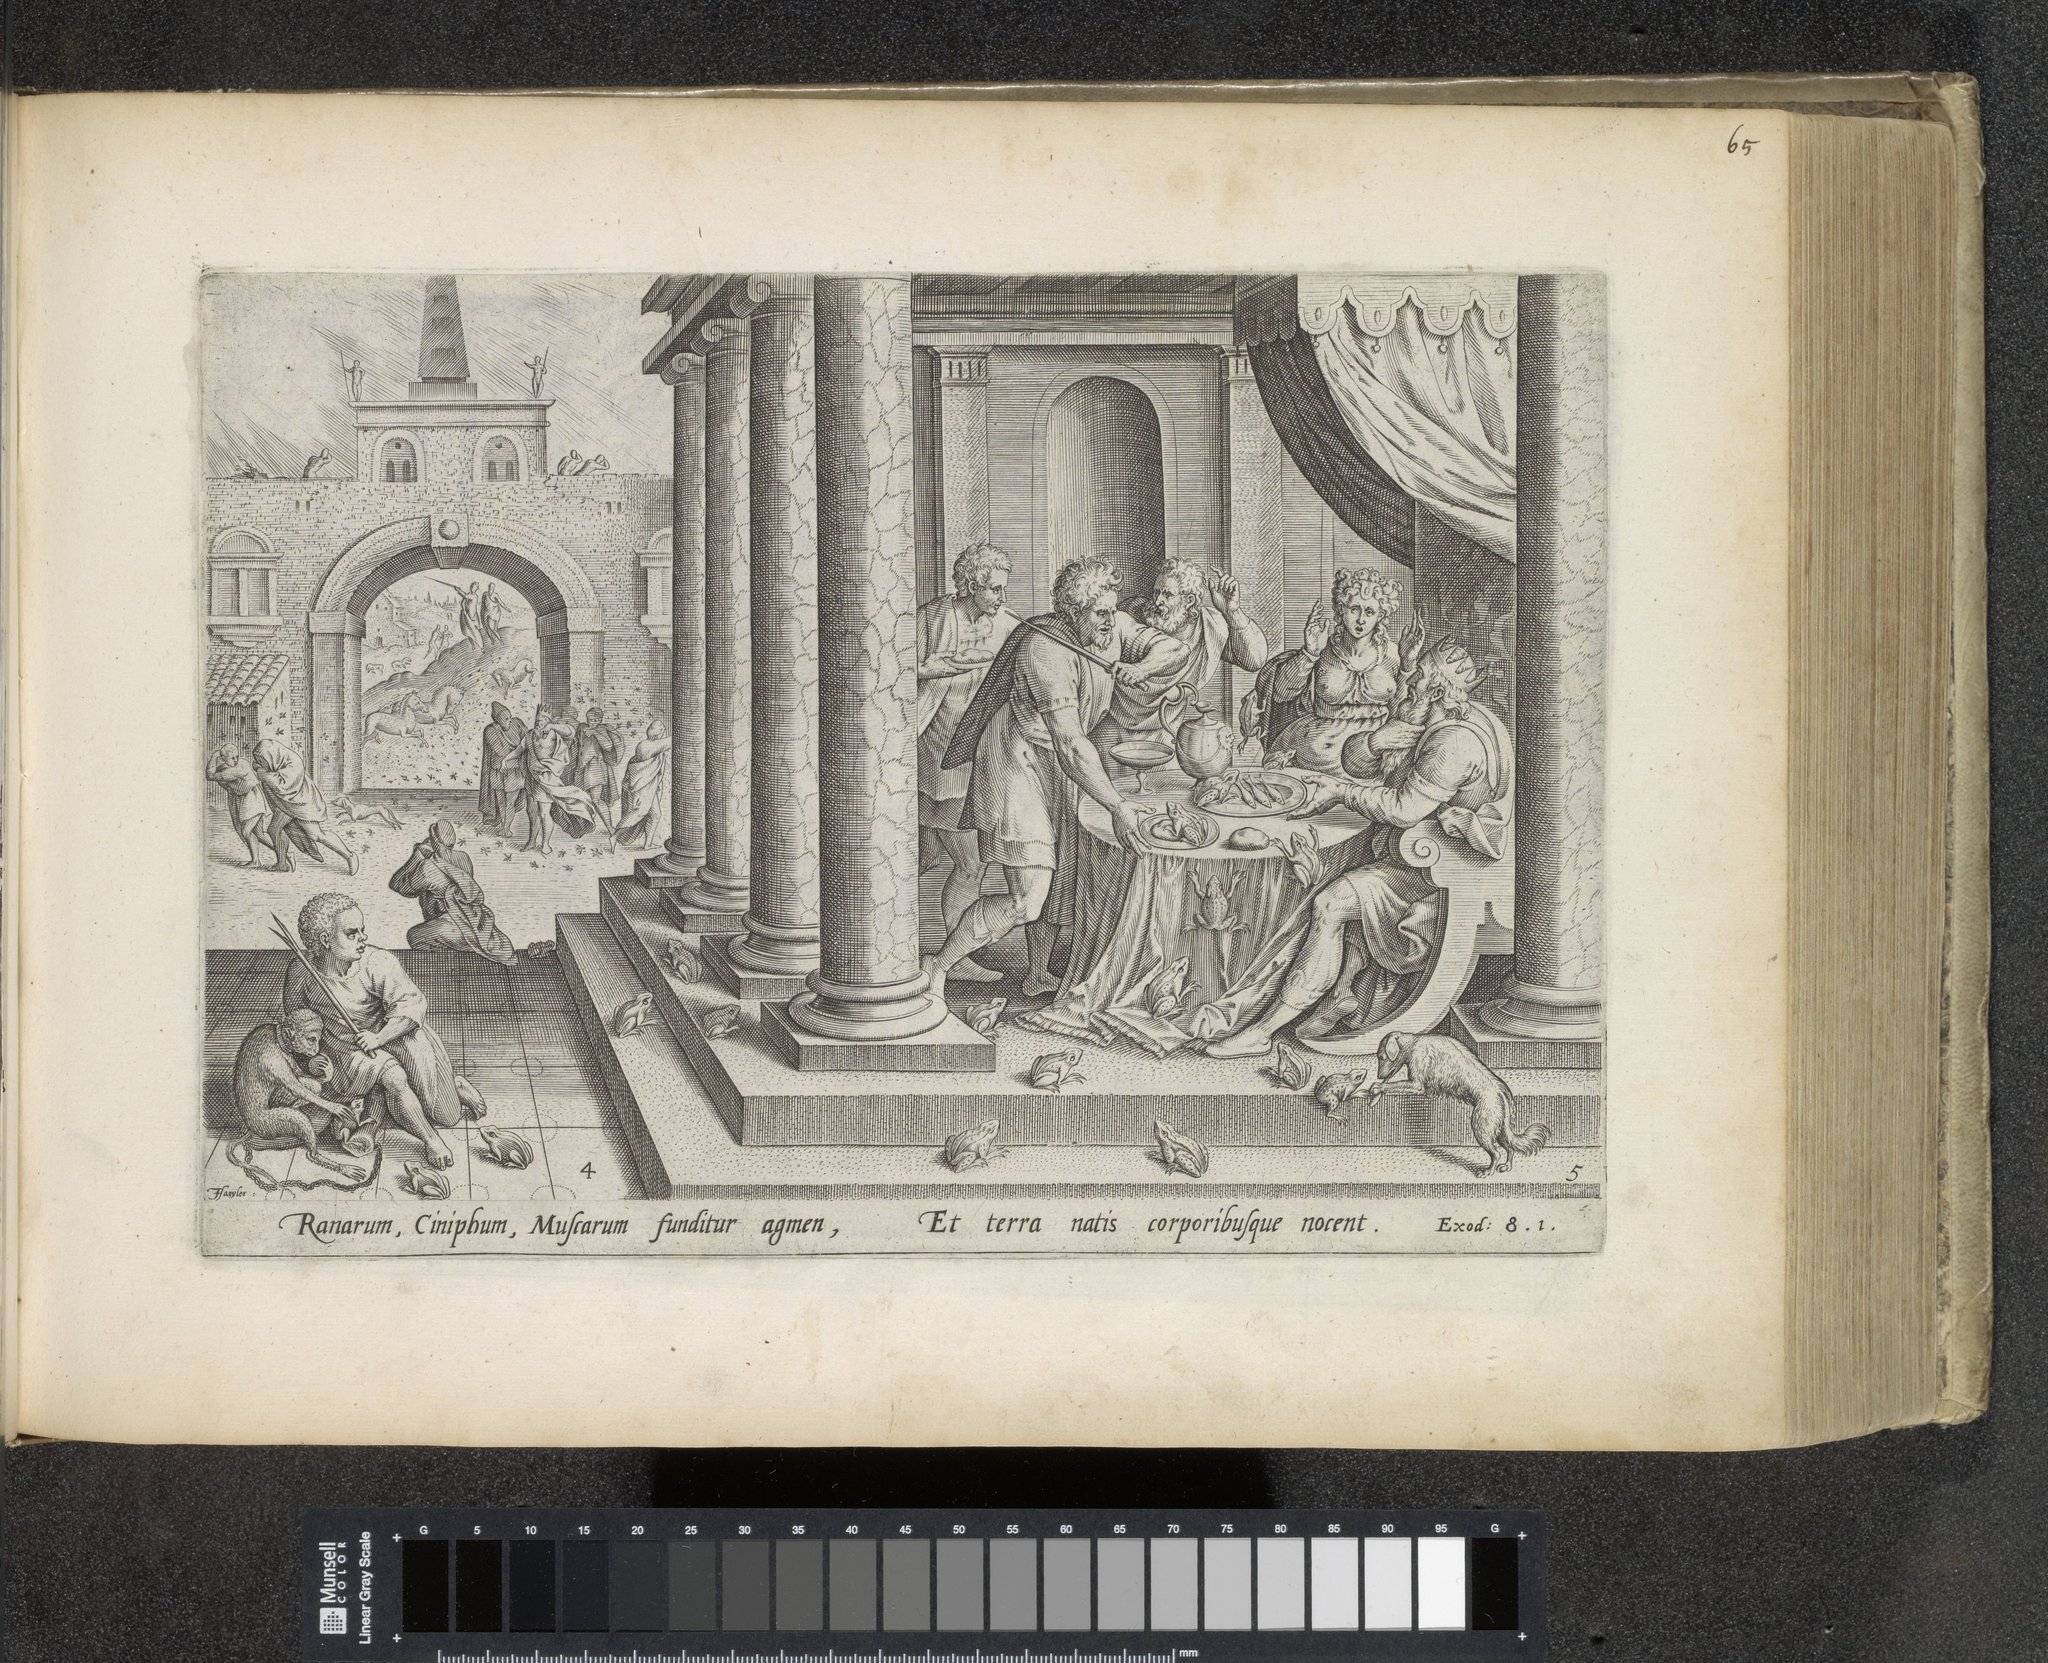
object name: album leaf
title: Theatrum Biblicum Hoc Est Historiae Sacrae Veteris et Novi Testamenti Tabulis Aeneis Expressae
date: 1579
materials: paper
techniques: engraving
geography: antwerp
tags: the plague of frogs: aaron stretches out his hand over the water of egypt; frogs come out and cover the land, the plague of lice: aaron strikes the ground with his rod and the dust turns into lice, the plague of flies which fill the houses of the egyptians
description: Op de voorgrond de tweede plaag die God over Egypte liet komen: een kikkerplaag. Een groep mensen zit aan tafel met rondom overal kikkers. Op de achtergrond wordt de farao aangevallen door muggen en steekvliegen. Op de achtergrond Aäron met zijn staf en Mozes. Onder de voorstelling een verwijzing in het Latijn naar de Bijbeltekst in Ex. 8:1. Deze prent maakt deel uit van een album.